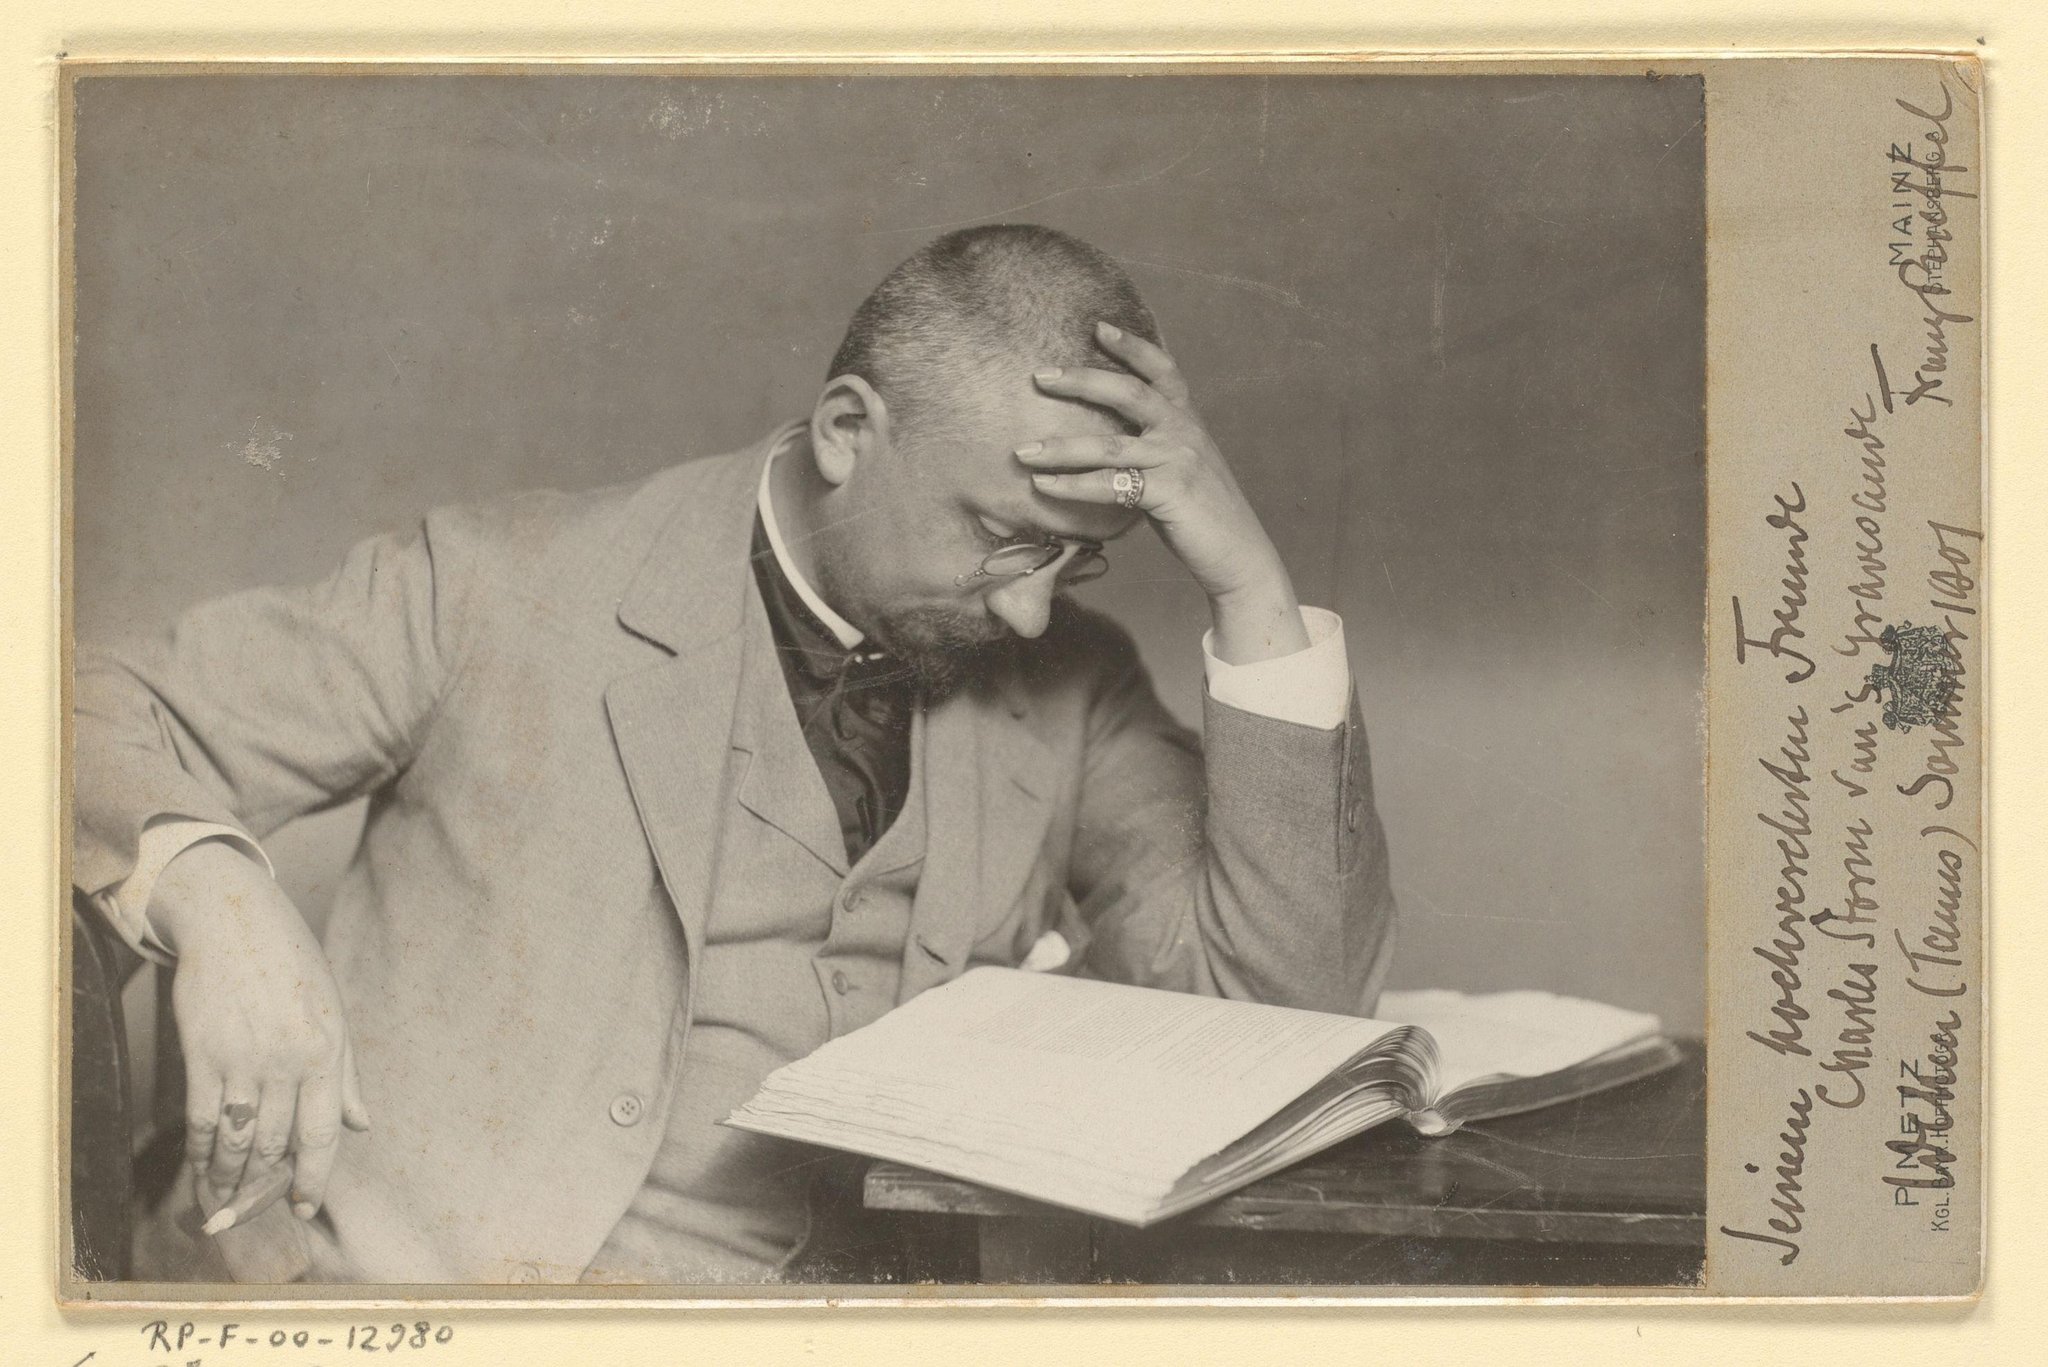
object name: cabinet photograph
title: Portret van Franz Rieffel, lezend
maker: p. metz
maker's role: fotograaf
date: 1901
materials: paper, cardboard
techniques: gelatin silver print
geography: mainz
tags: reading, historical persons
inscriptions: inscription: ‘No der Platte/ P. Metz (...) Haake & Albers, Frankfurt a.M.’, inscription: ‘Seinem hochverehrten Freunde/ Charles Storm van 's Gravensande/ Wehen (Taunus) Sommer 1901 Franz Rieffel’